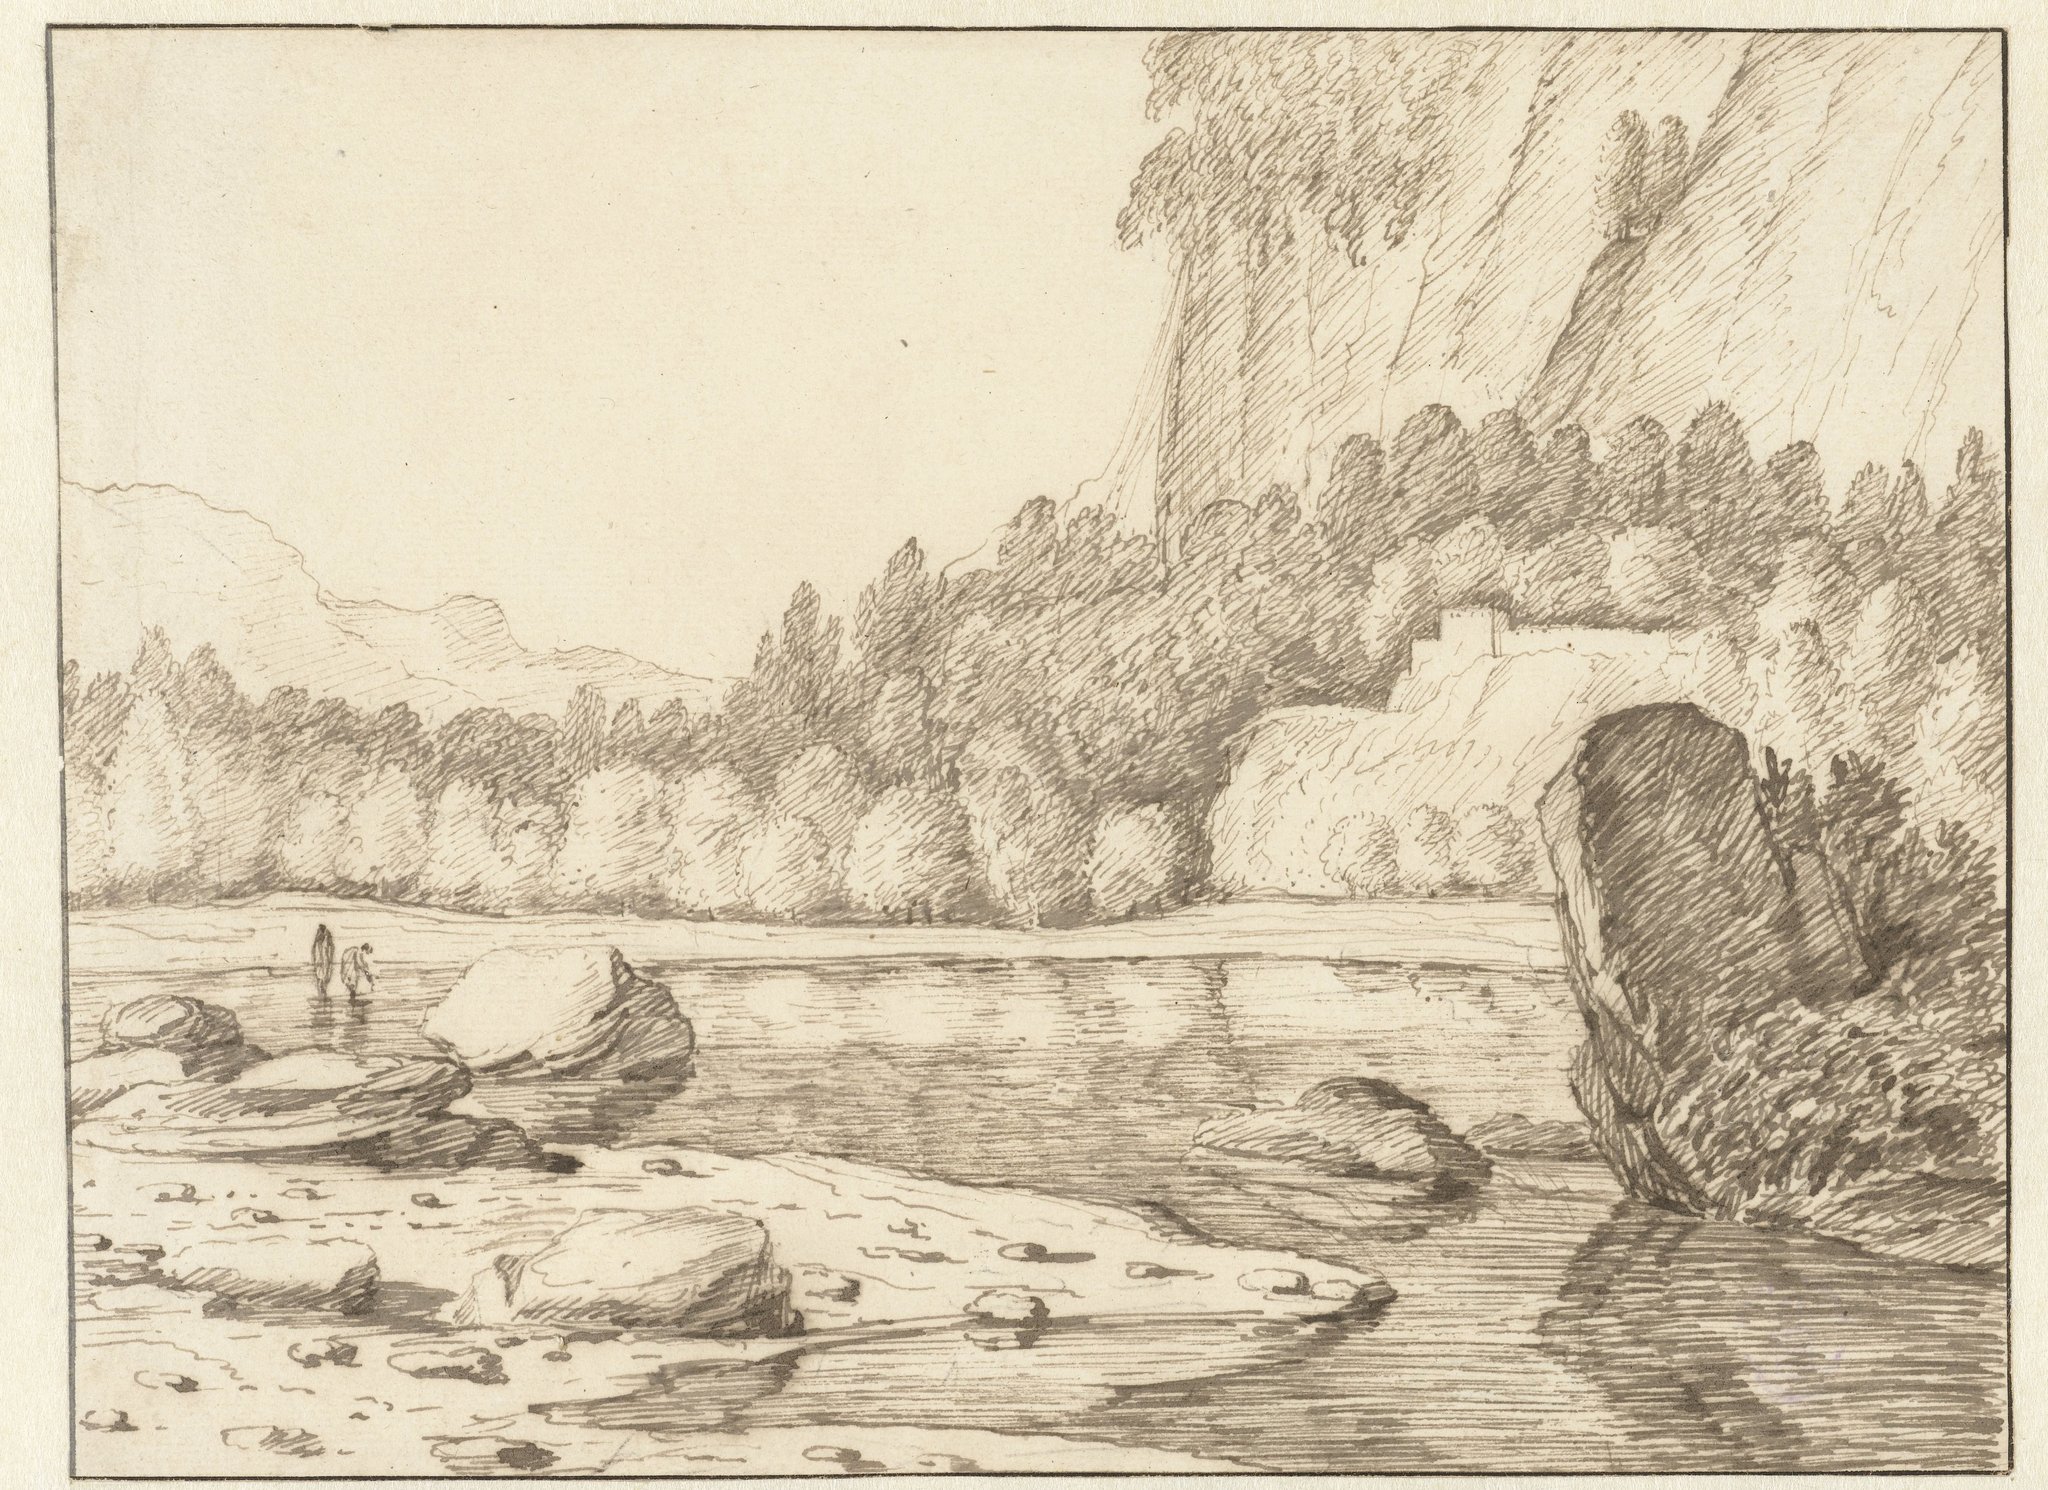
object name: drawing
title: Meer in rotsachtig landschap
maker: jacob esselens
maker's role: draughtsman, print maker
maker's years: 1626-1687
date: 1636-1687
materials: ink, paper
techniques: pen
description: Rotsachtig landschap met links in de verte twee figuren die in een meer staan.